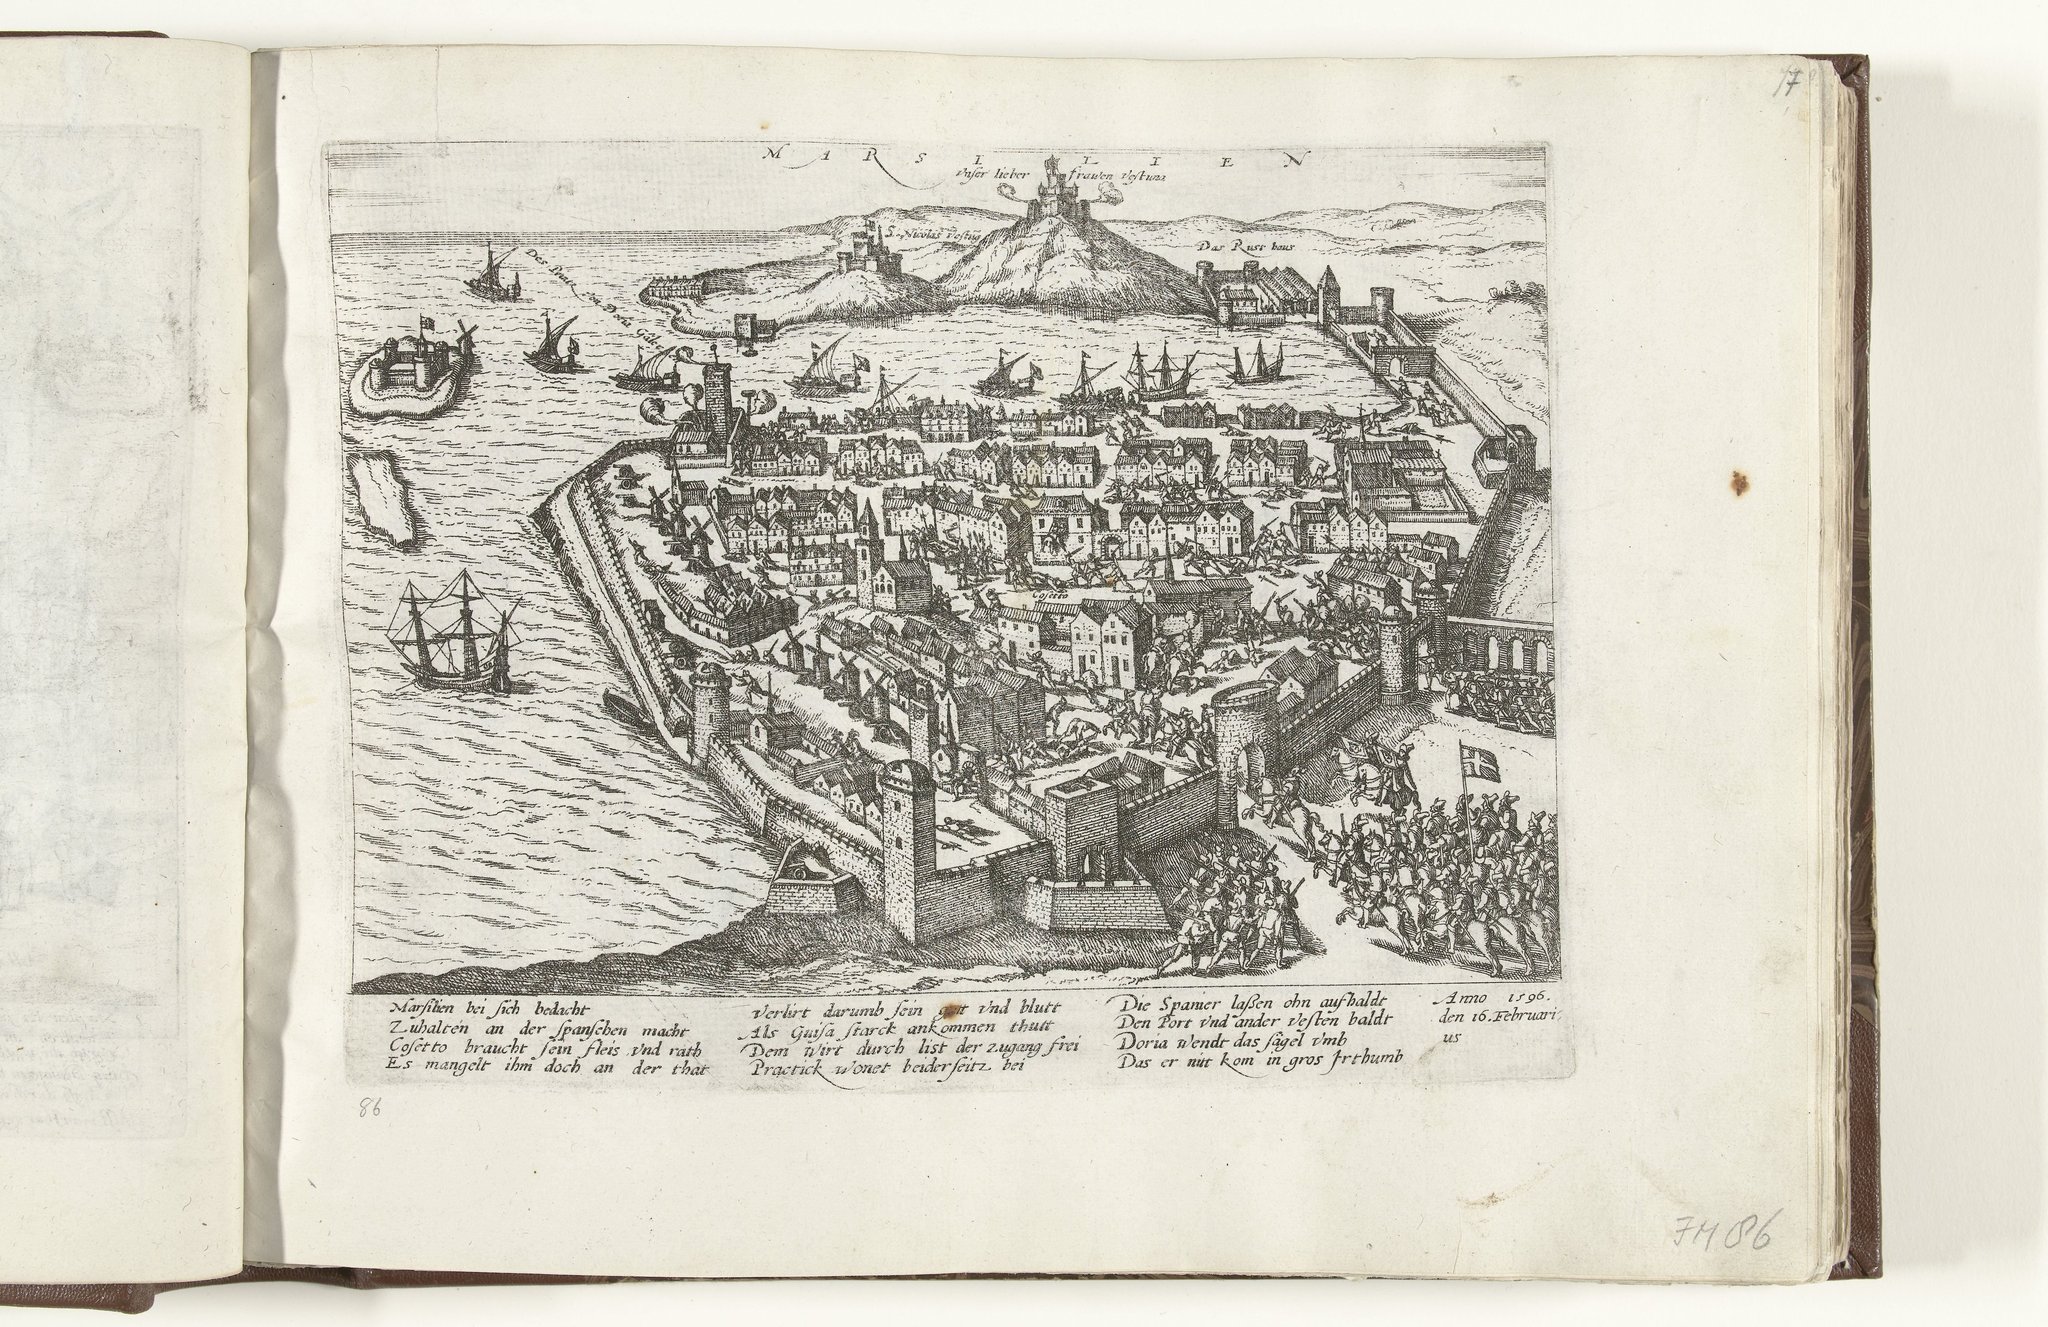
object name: print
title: Guise verovert Marseille, 1596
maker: frans hogenberg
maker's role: print maker, publisher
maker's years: 1538-1590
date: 1596-1612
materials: paper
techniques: etching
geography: cologne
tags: battle, fighting in general, marseille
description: De troepen van de Guise trekken Marseille in, gevechten in de straten, 16 februari 1596. Met onderschrift van 12 regels in het Duits. Ongenummerd.